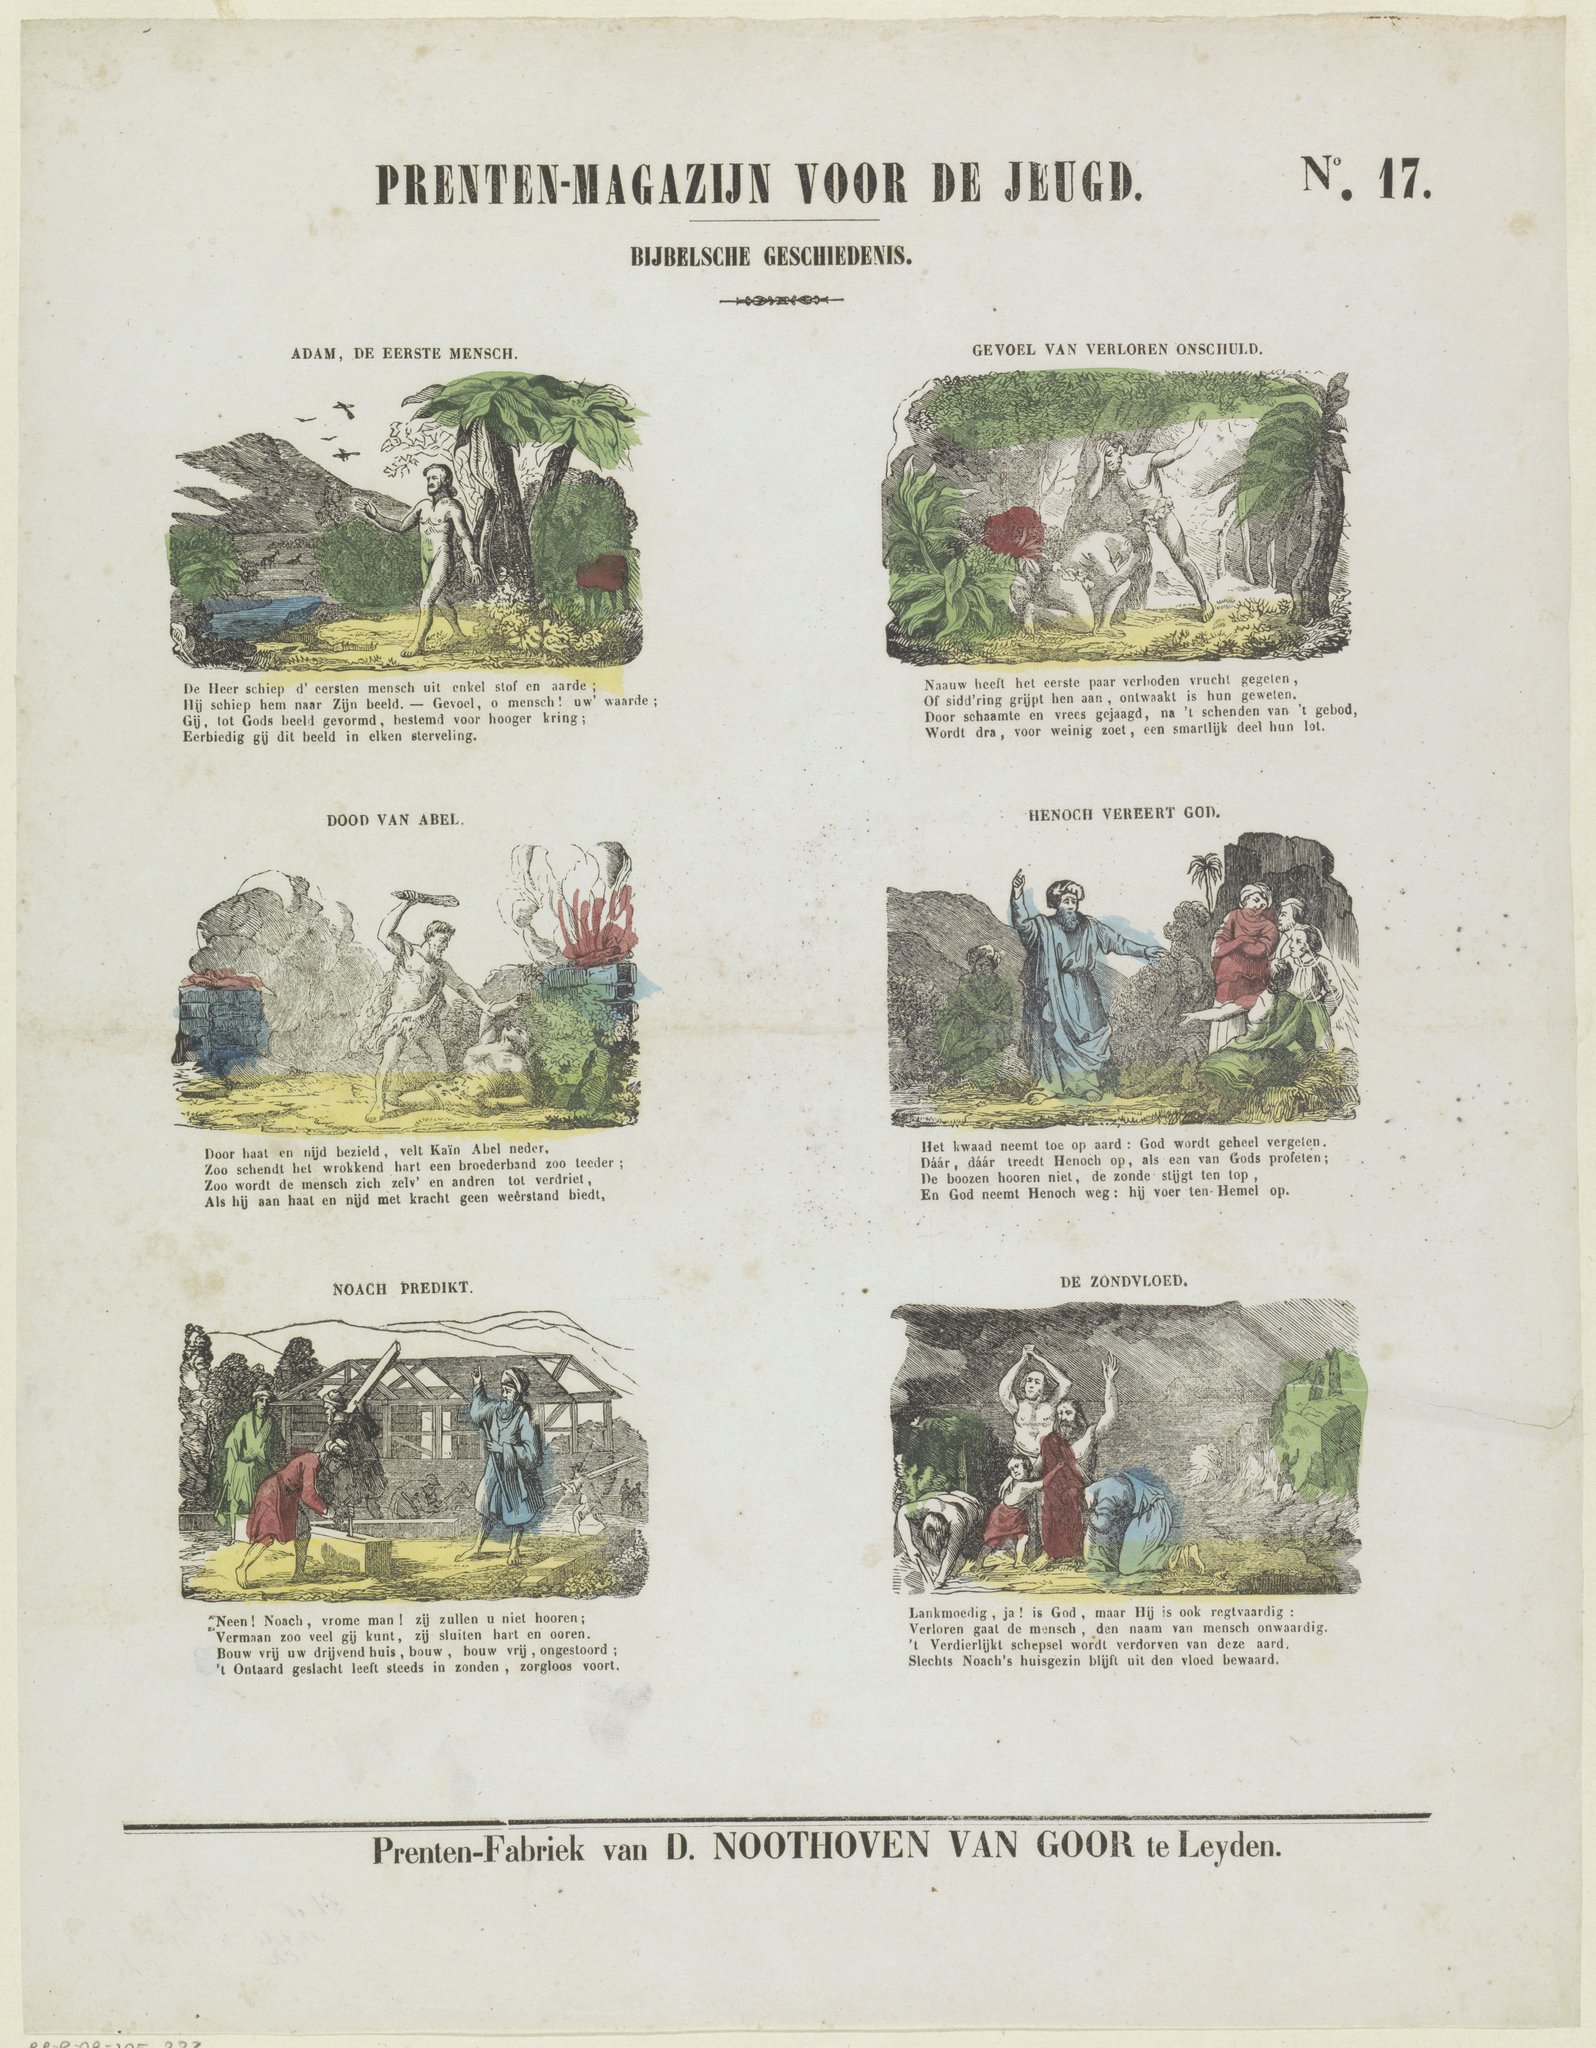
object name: print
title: Bijbelsche geschiedenis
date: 1850-1881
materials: paper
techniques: colour, letterpress printing, engraving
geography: leiden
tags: abel's death, adam as founder, initiator, story of noah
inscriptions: collector's mark: Lugt 2760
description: Blad met 6 voorstellingen van verhalen uit het Oude Testament, zoals de dood van Abel en Noach die predikt. Boven elke voorstelling een titel en onder elke voorstelling een vierregelig vers. Genummerd rechtsboven: No. 17.